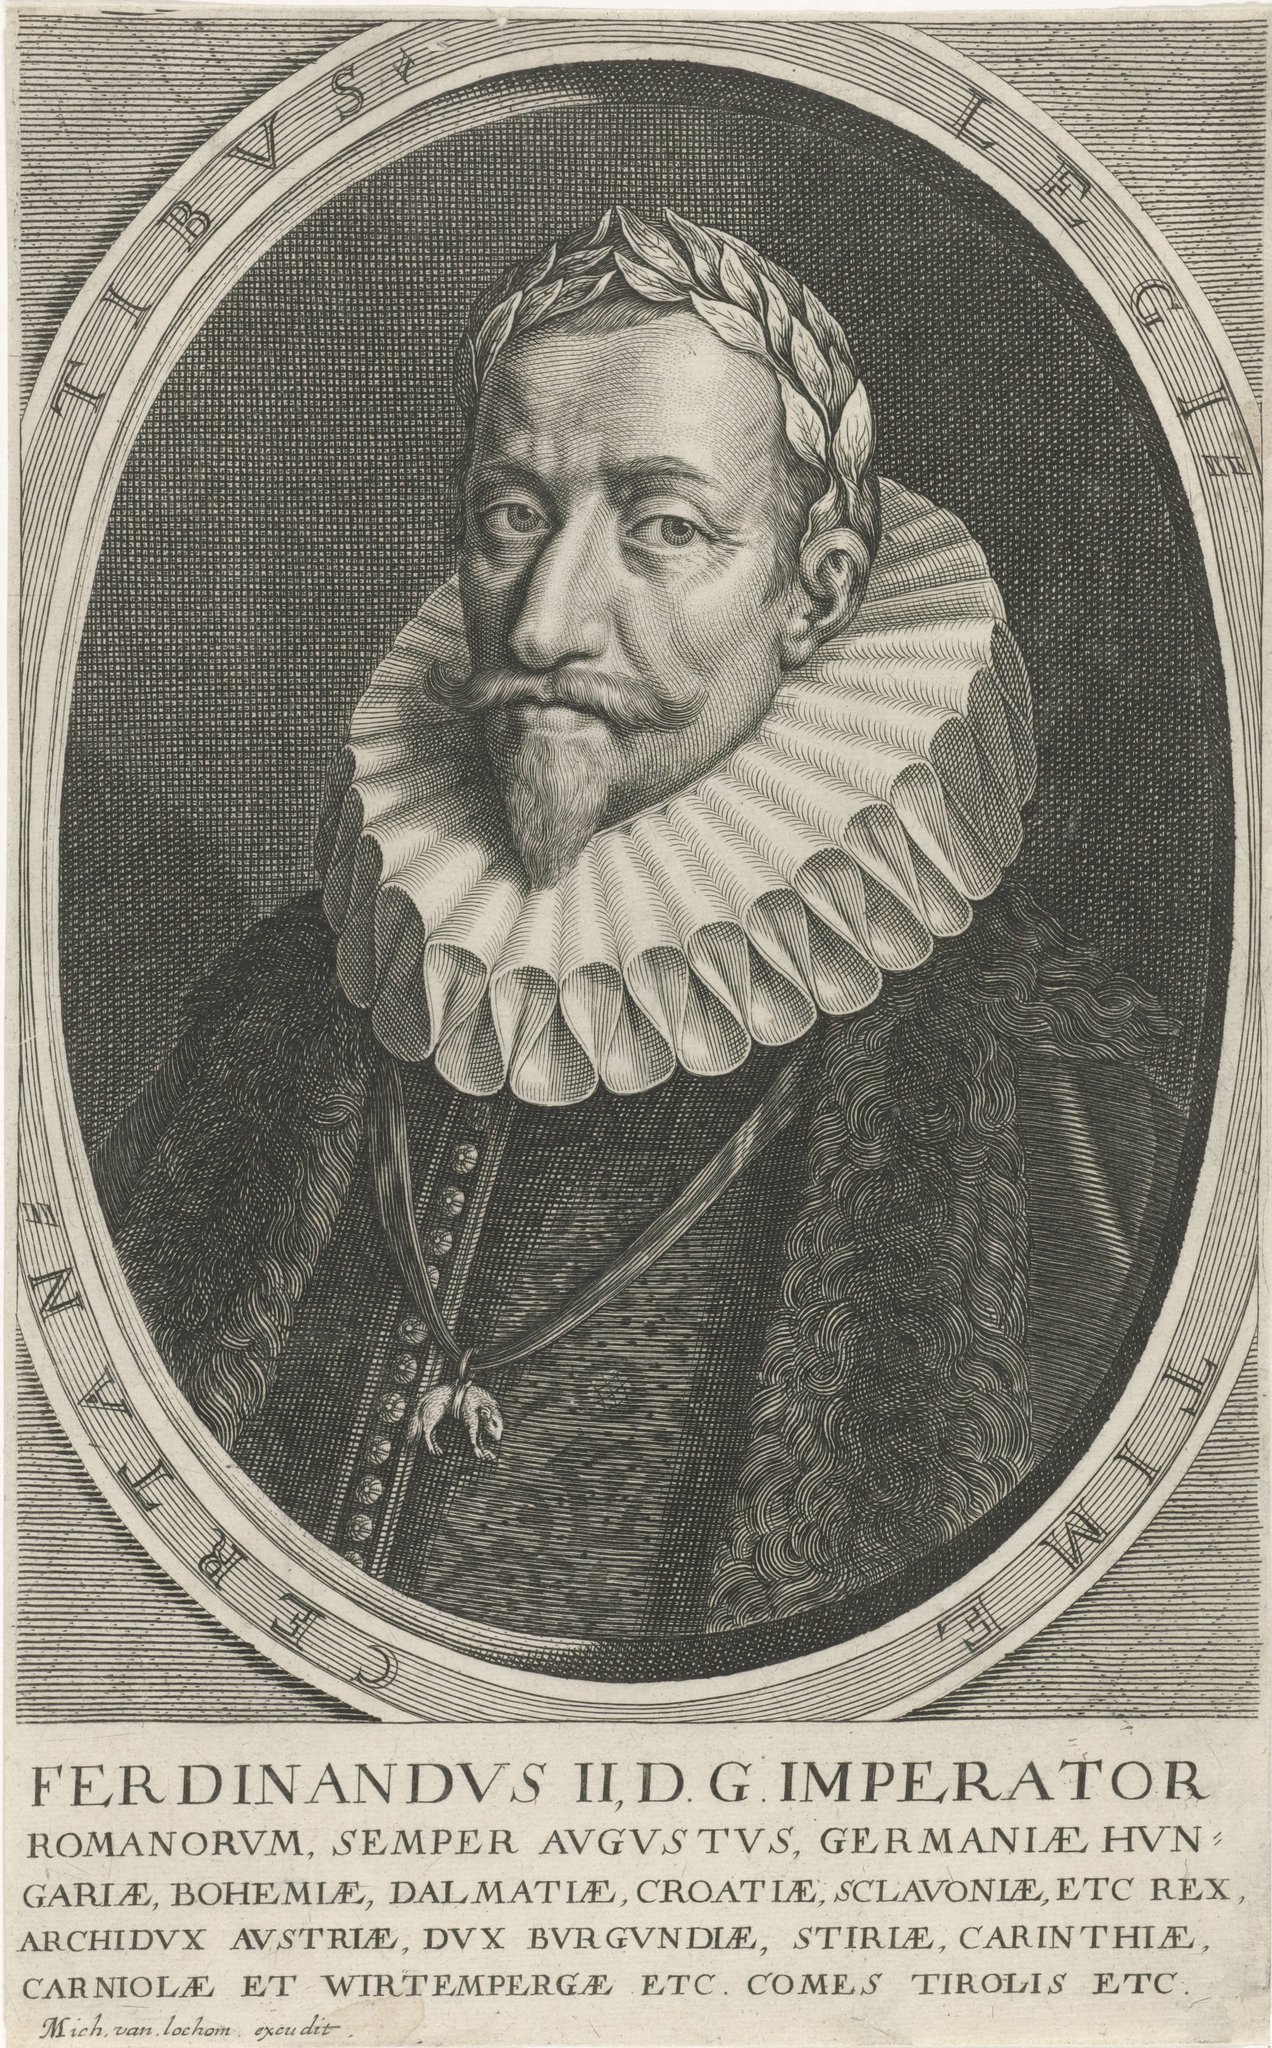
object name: print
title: Portret van keizer Ferdinand II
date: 1611-1647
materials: paper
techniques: engraving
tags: ferdinand ii (duits keizer), knighthood order of the golden fleece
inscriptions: collector's mark: Lugt 2228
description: Portret van Ferdinand II, Duits keizer. Om zijn hals een lint met het symbool van de orde van het Gulden Vlies.